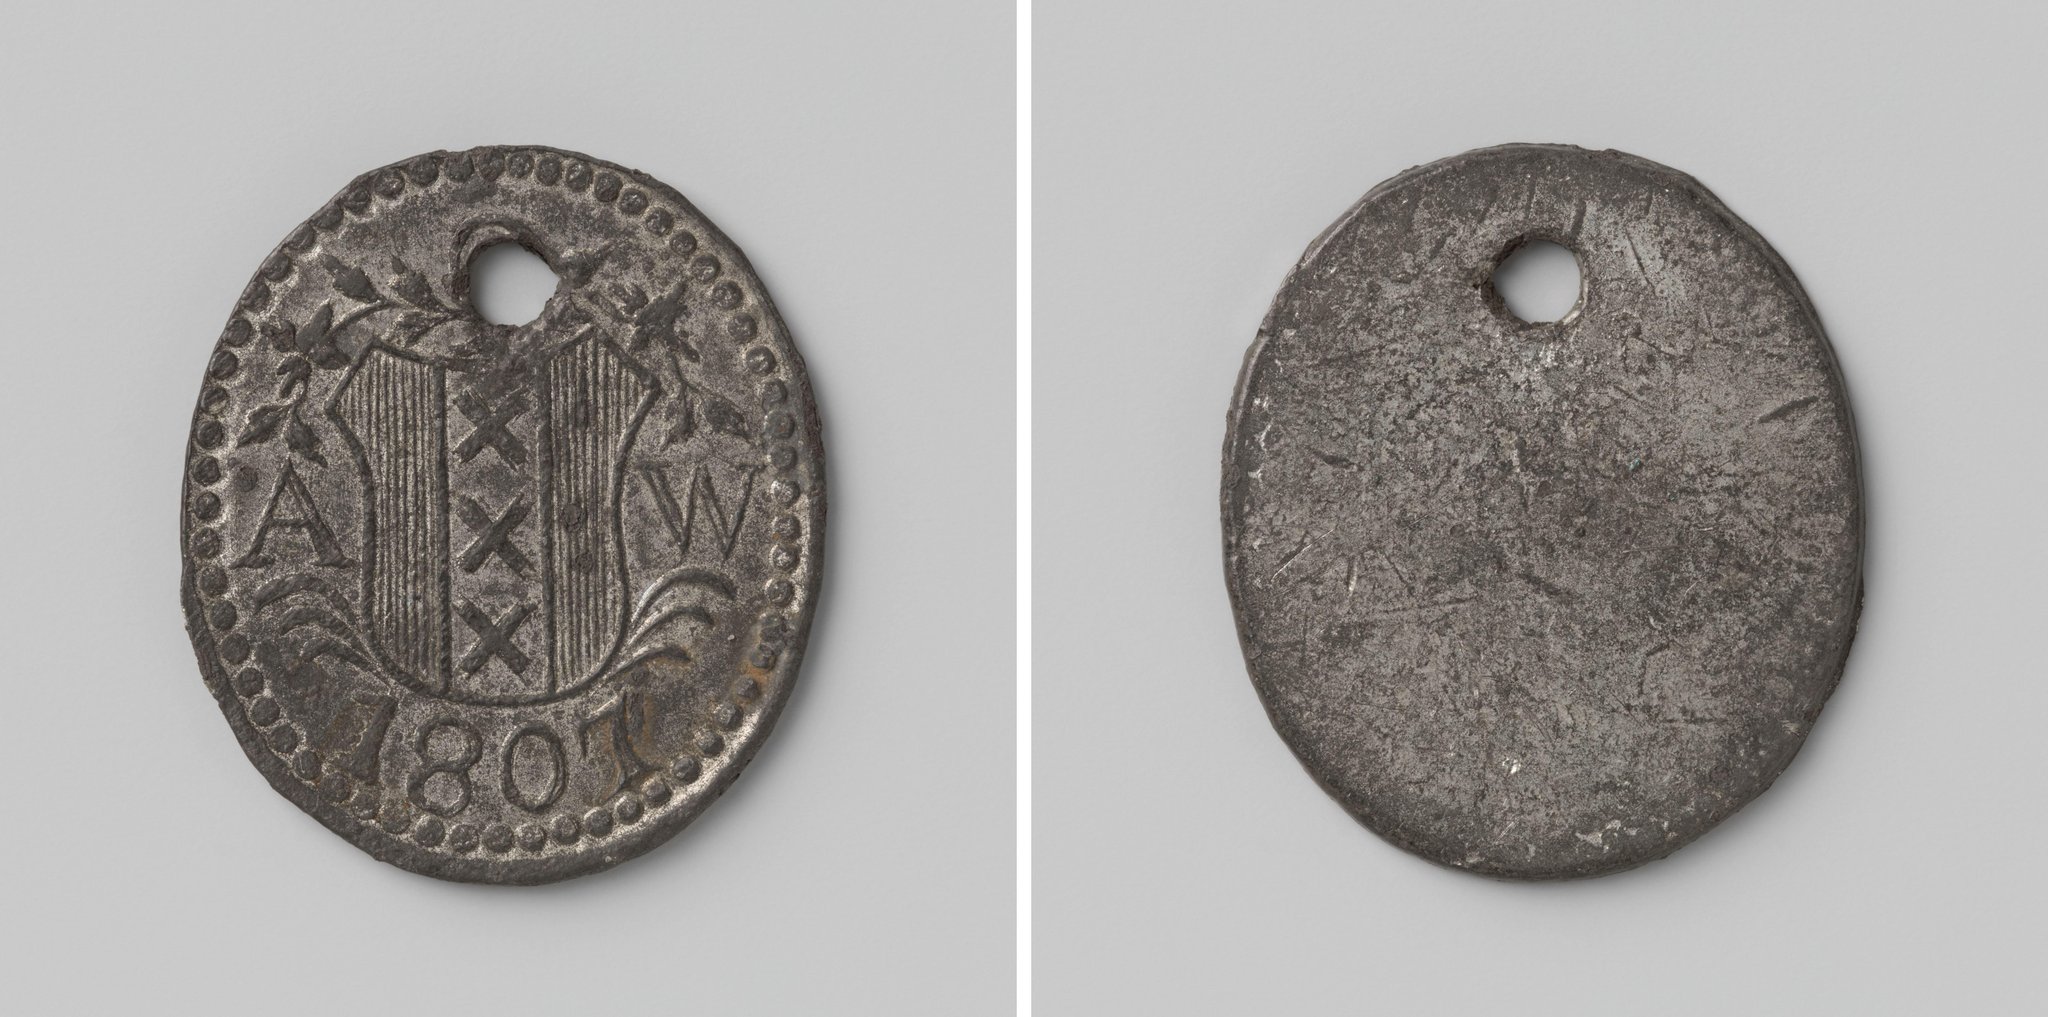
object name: hondenbelastingloodje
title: Aalmoezeniersweeshuis te Amsterdam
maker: Anonymous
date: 1807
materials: tin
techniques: striking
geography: amsterdam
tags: amsterdam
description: Eenzijdig, ovaal tinnen loodje met gat erin. Voorzijde: wapenschild, omgeven door bladertakjes tussen opschrift AW boven jaartal. Keerzijde: blanco.